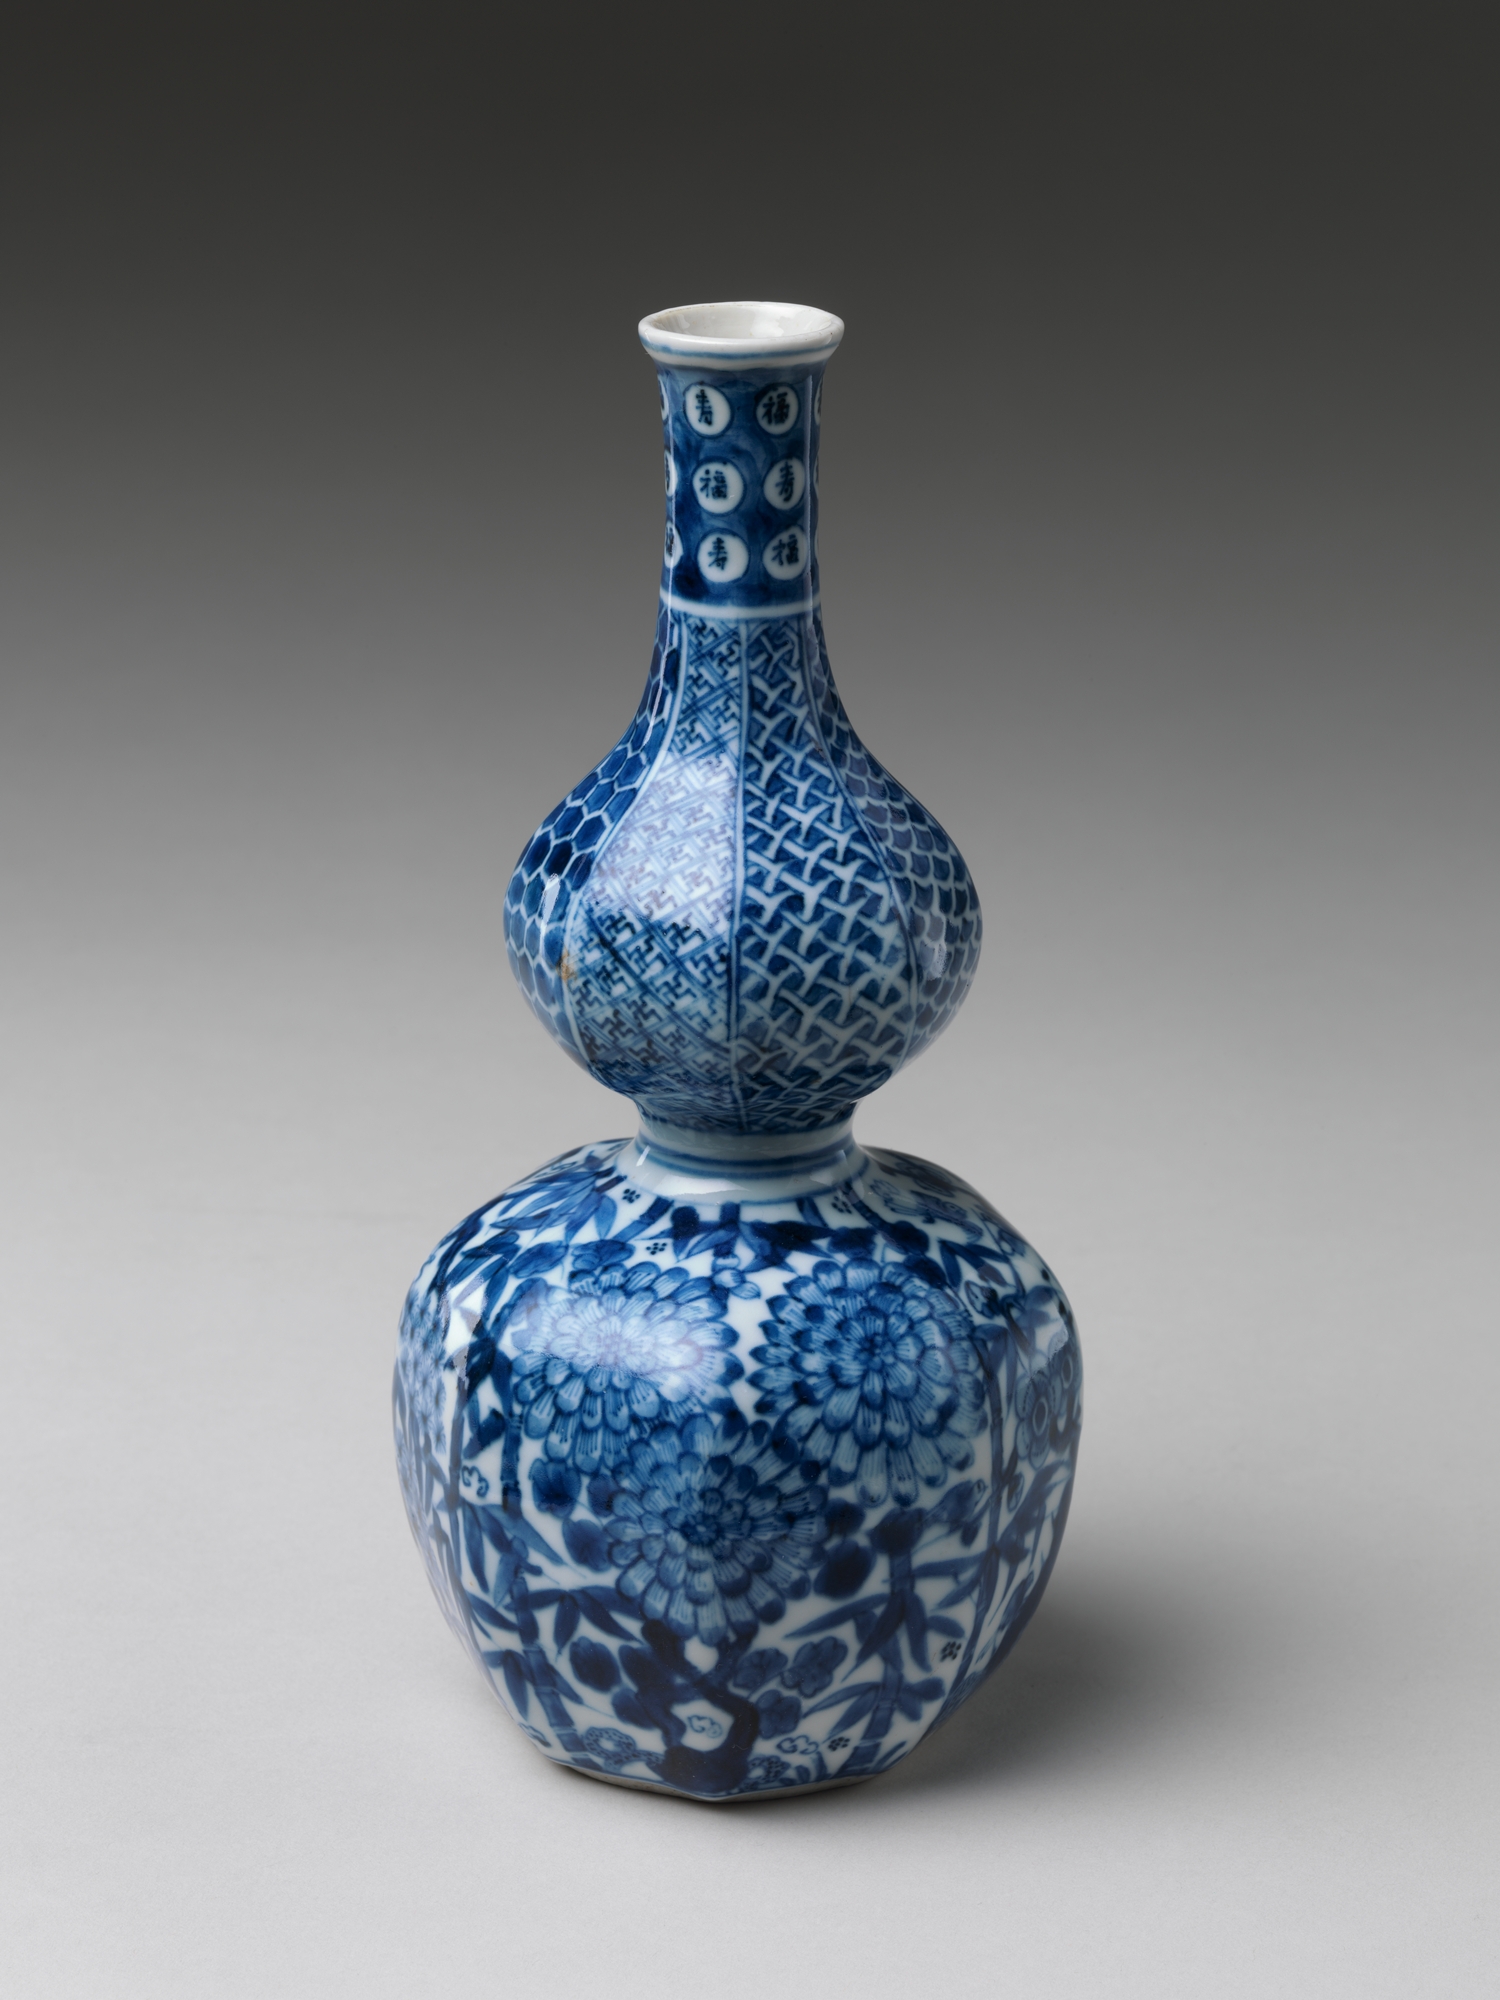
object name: bottle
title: Wine Bottle with Three Friends of Winter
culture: japanese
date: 1801-1900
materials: cobalt, glaze, porcelain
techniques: painting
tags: flowers